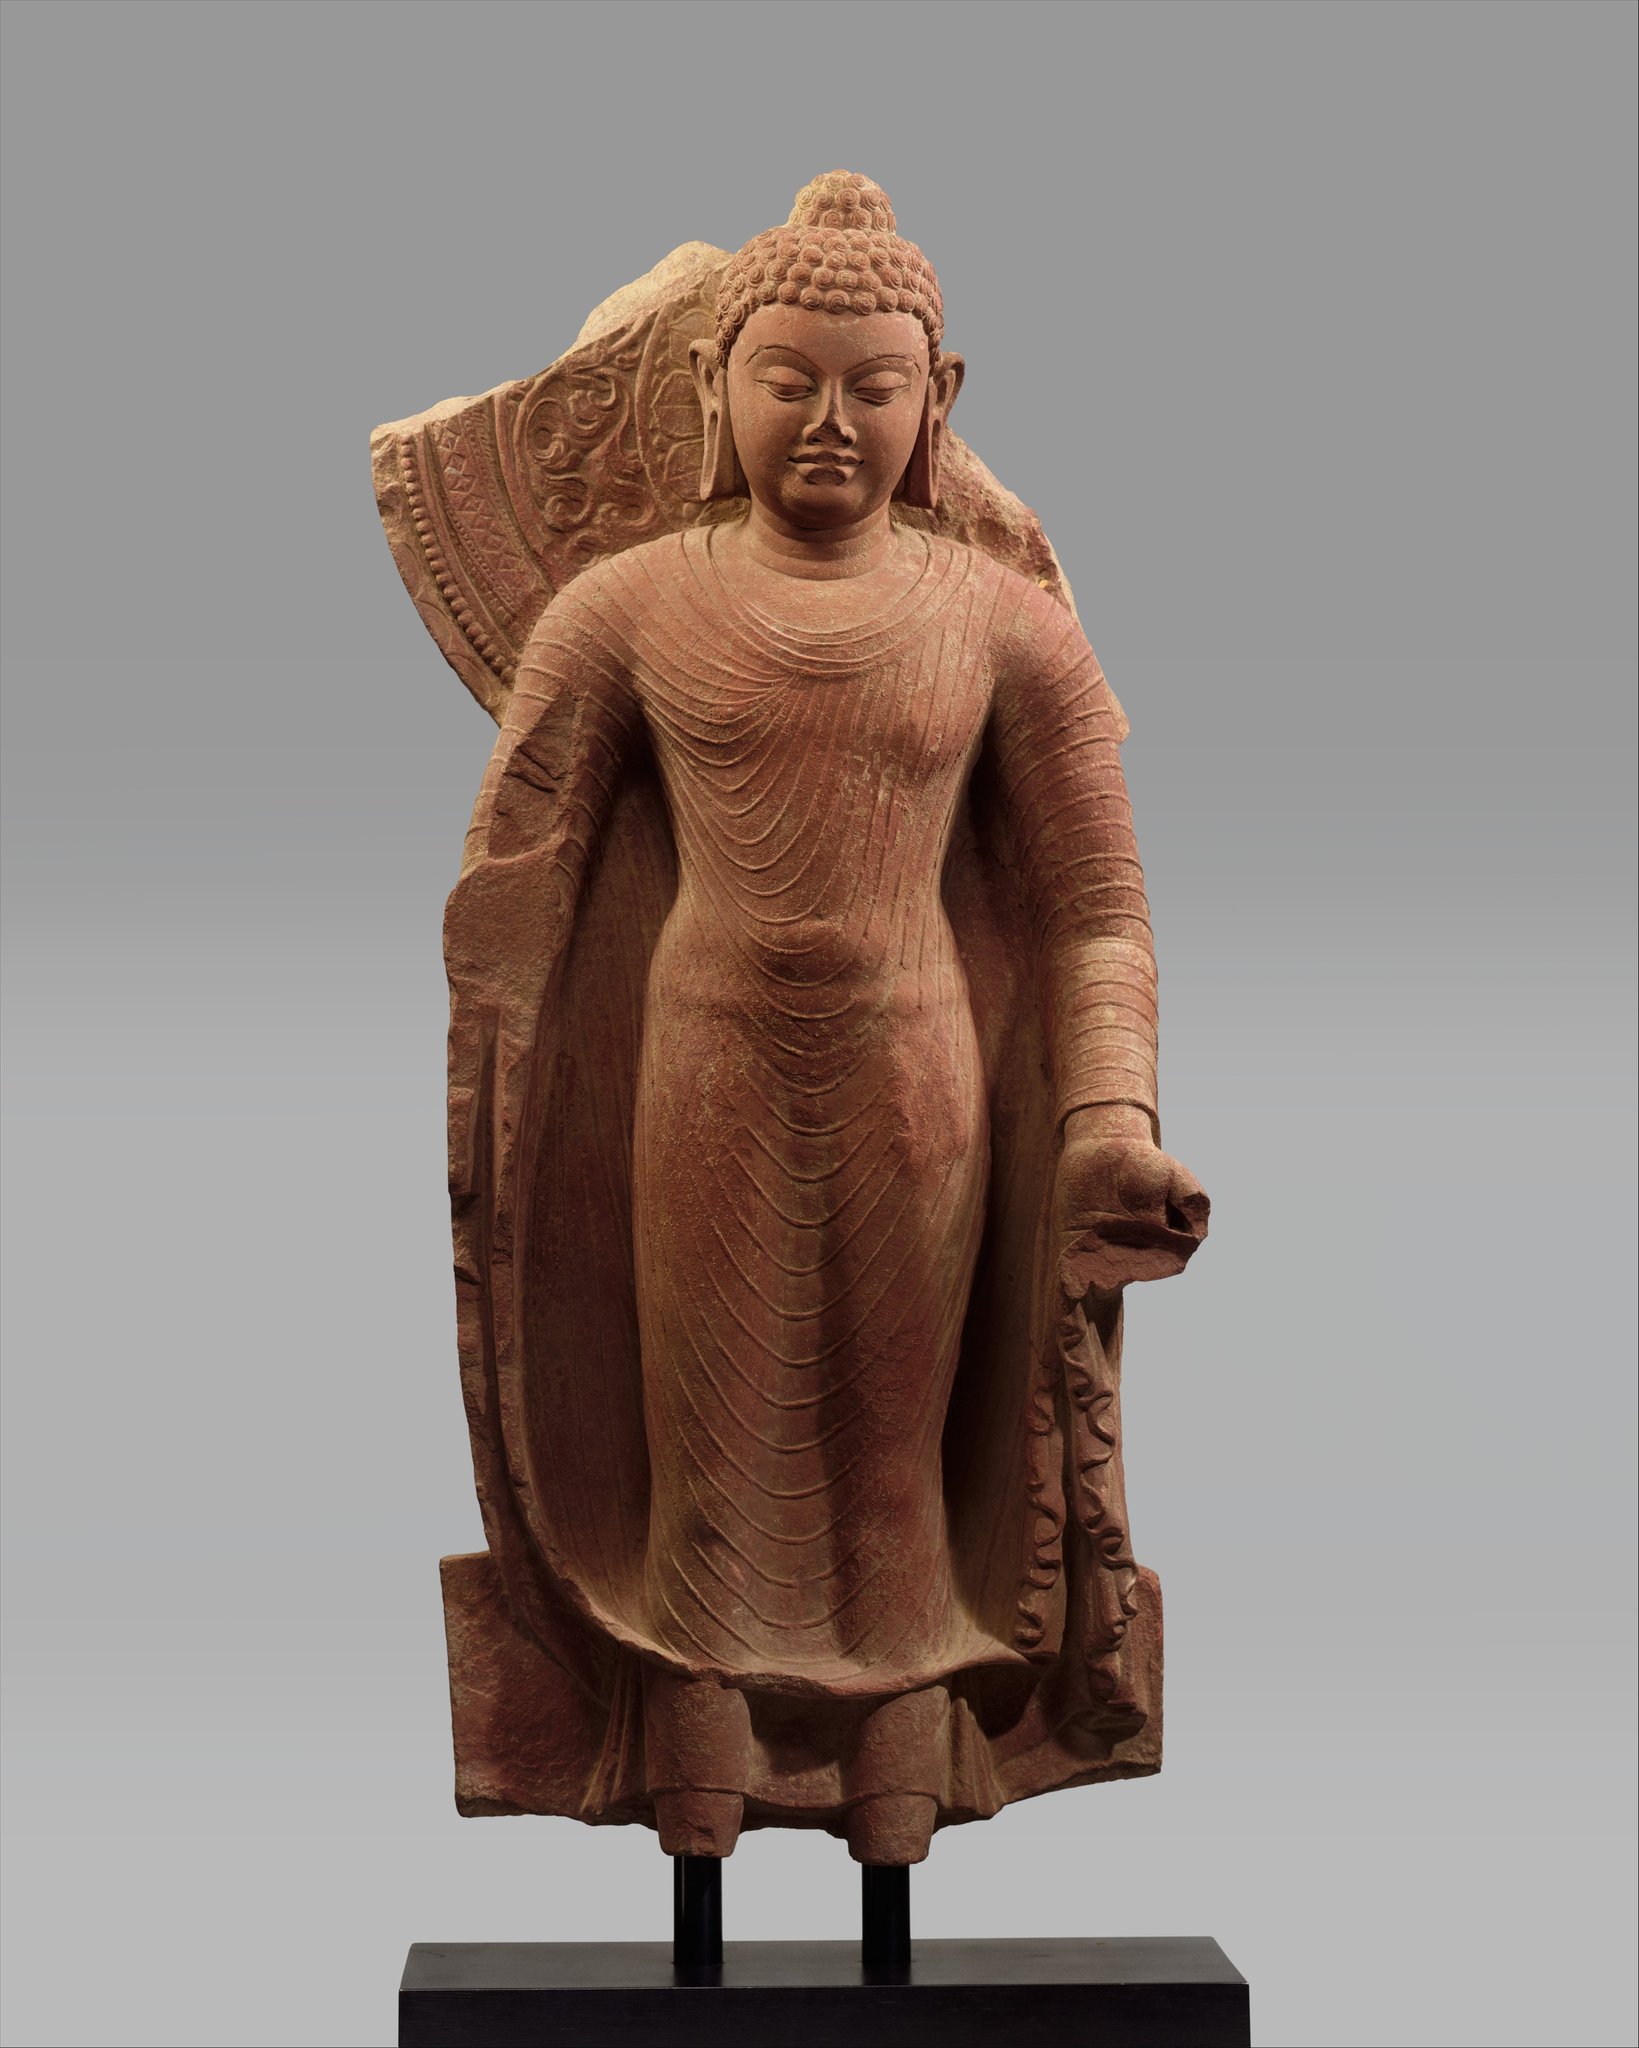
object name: figure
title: Standing Buddha Offering Protection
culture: indian, uttar pradesh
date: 467-500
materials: stone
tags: gupta,buddhism,buddha